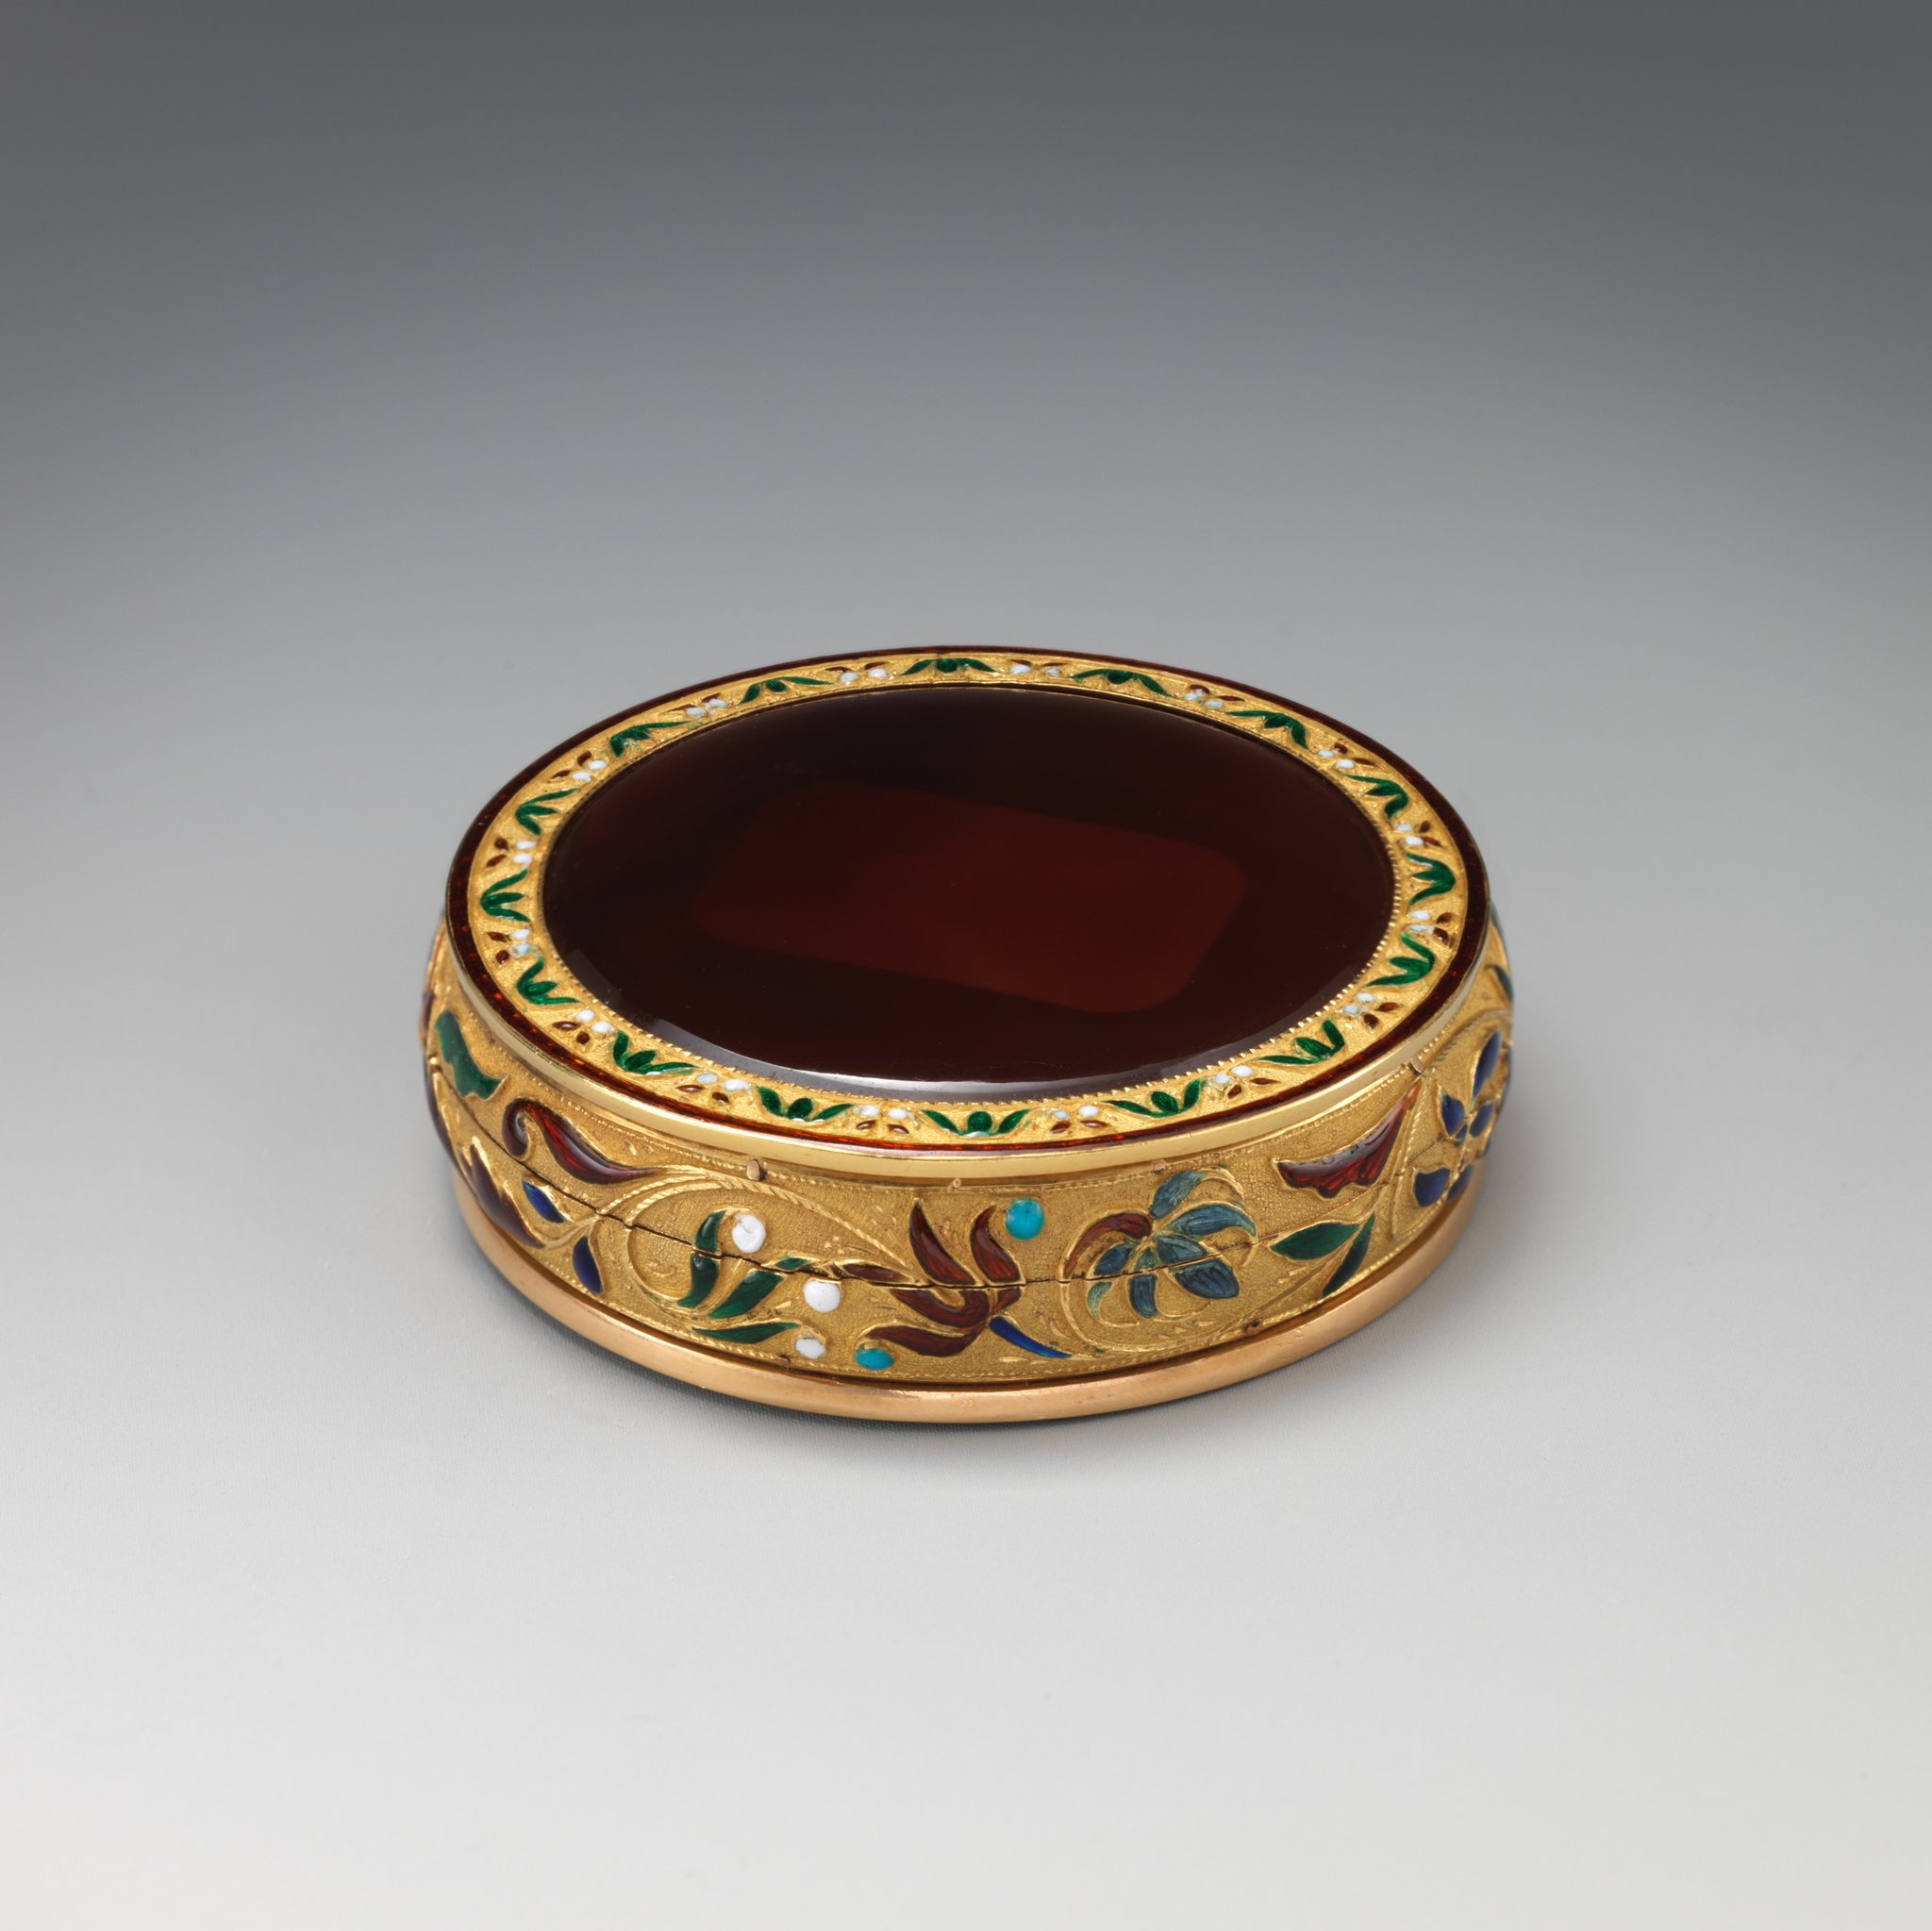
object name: box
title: Circular box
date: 1809-1819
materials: gemstone, enamel, gold